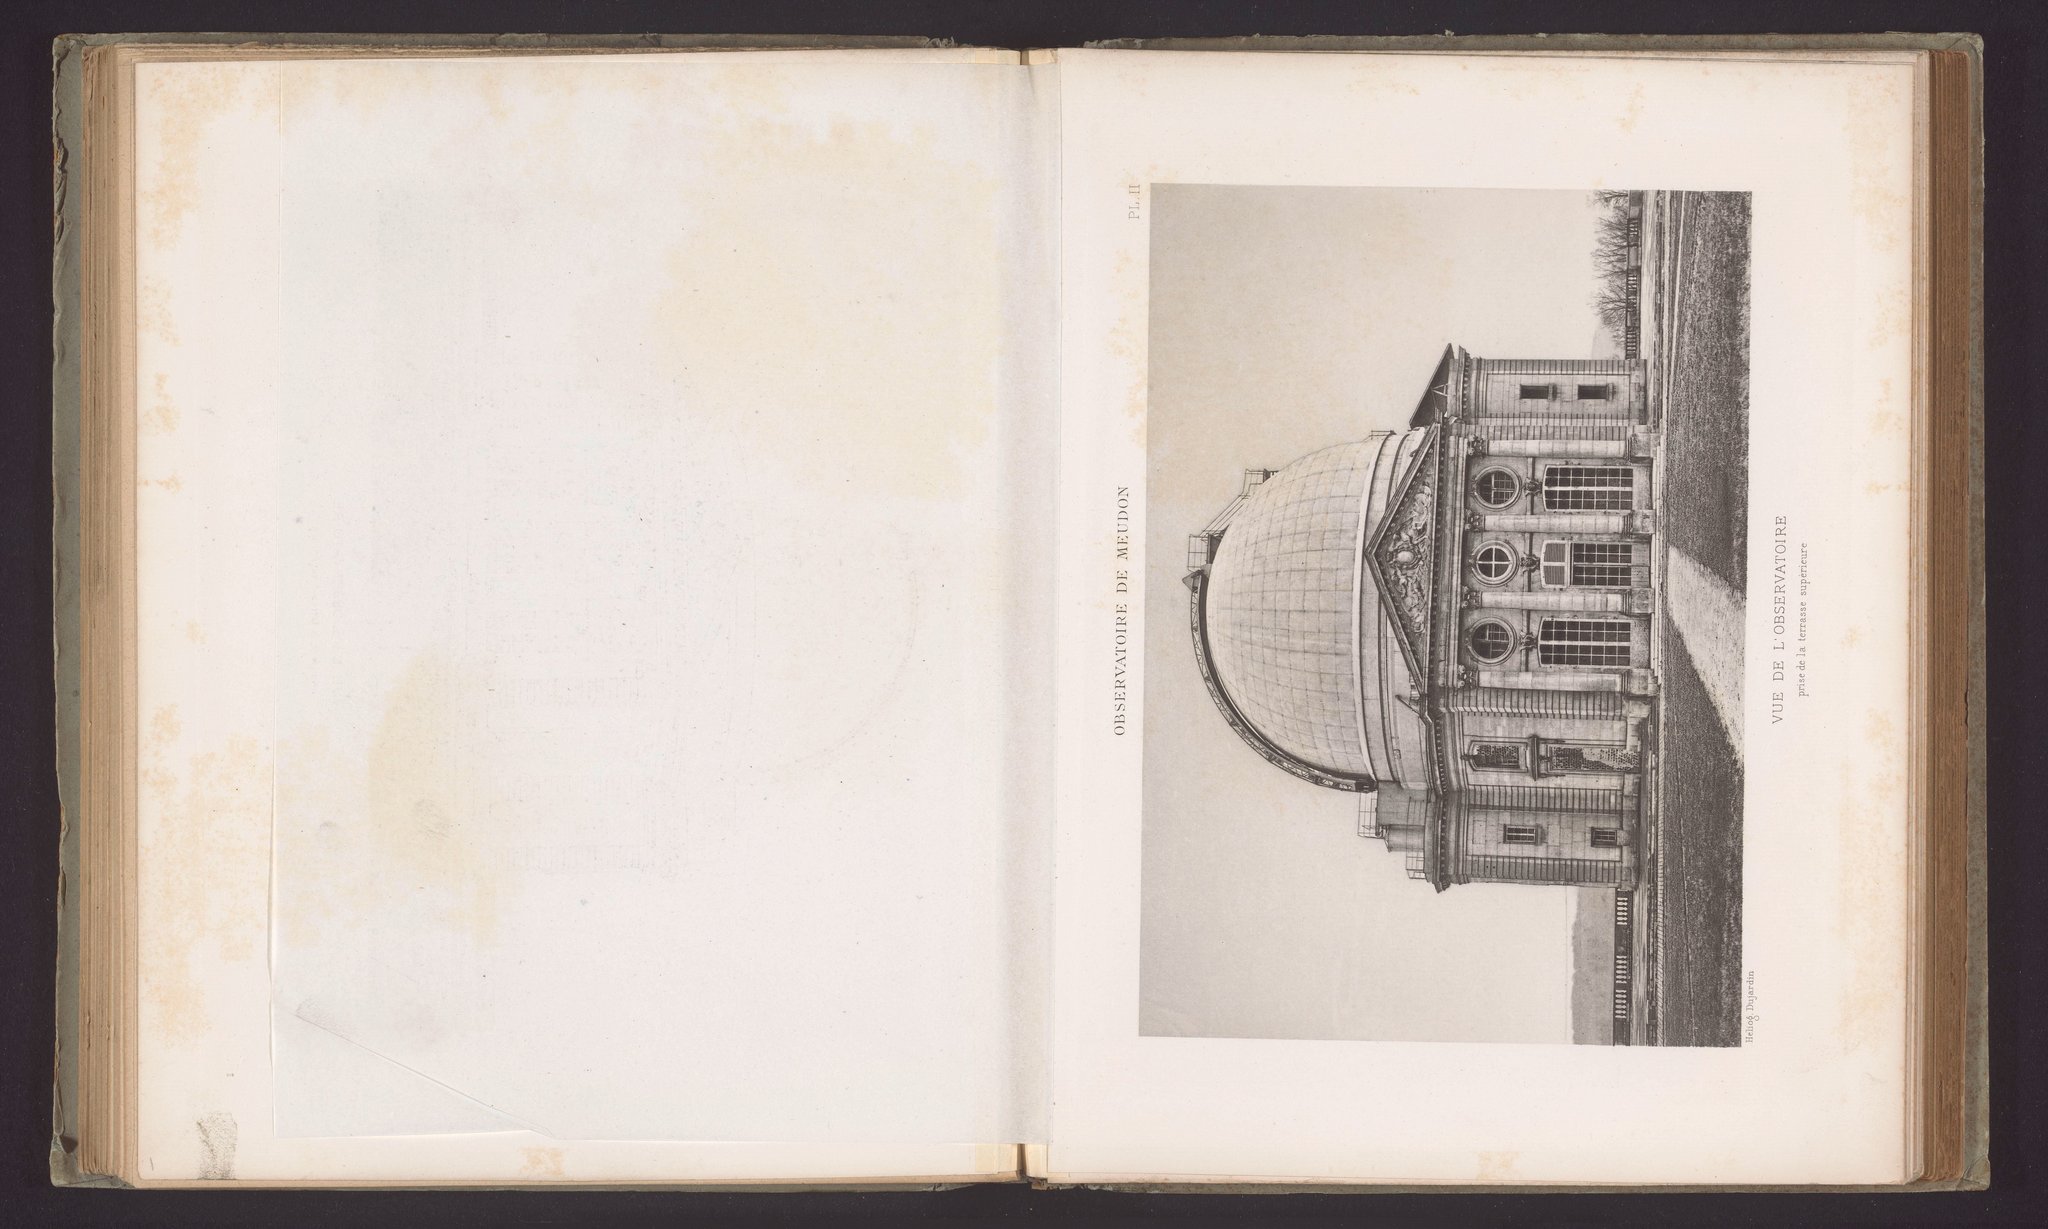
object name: page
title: Vue de l'observatoire prise de la terrasse supérieure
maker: dujardin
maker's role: printer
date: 1891-1896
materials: paper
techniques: photoaquatint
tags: observatory (~ astronomy)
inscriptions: inscription: ‘PL. II’